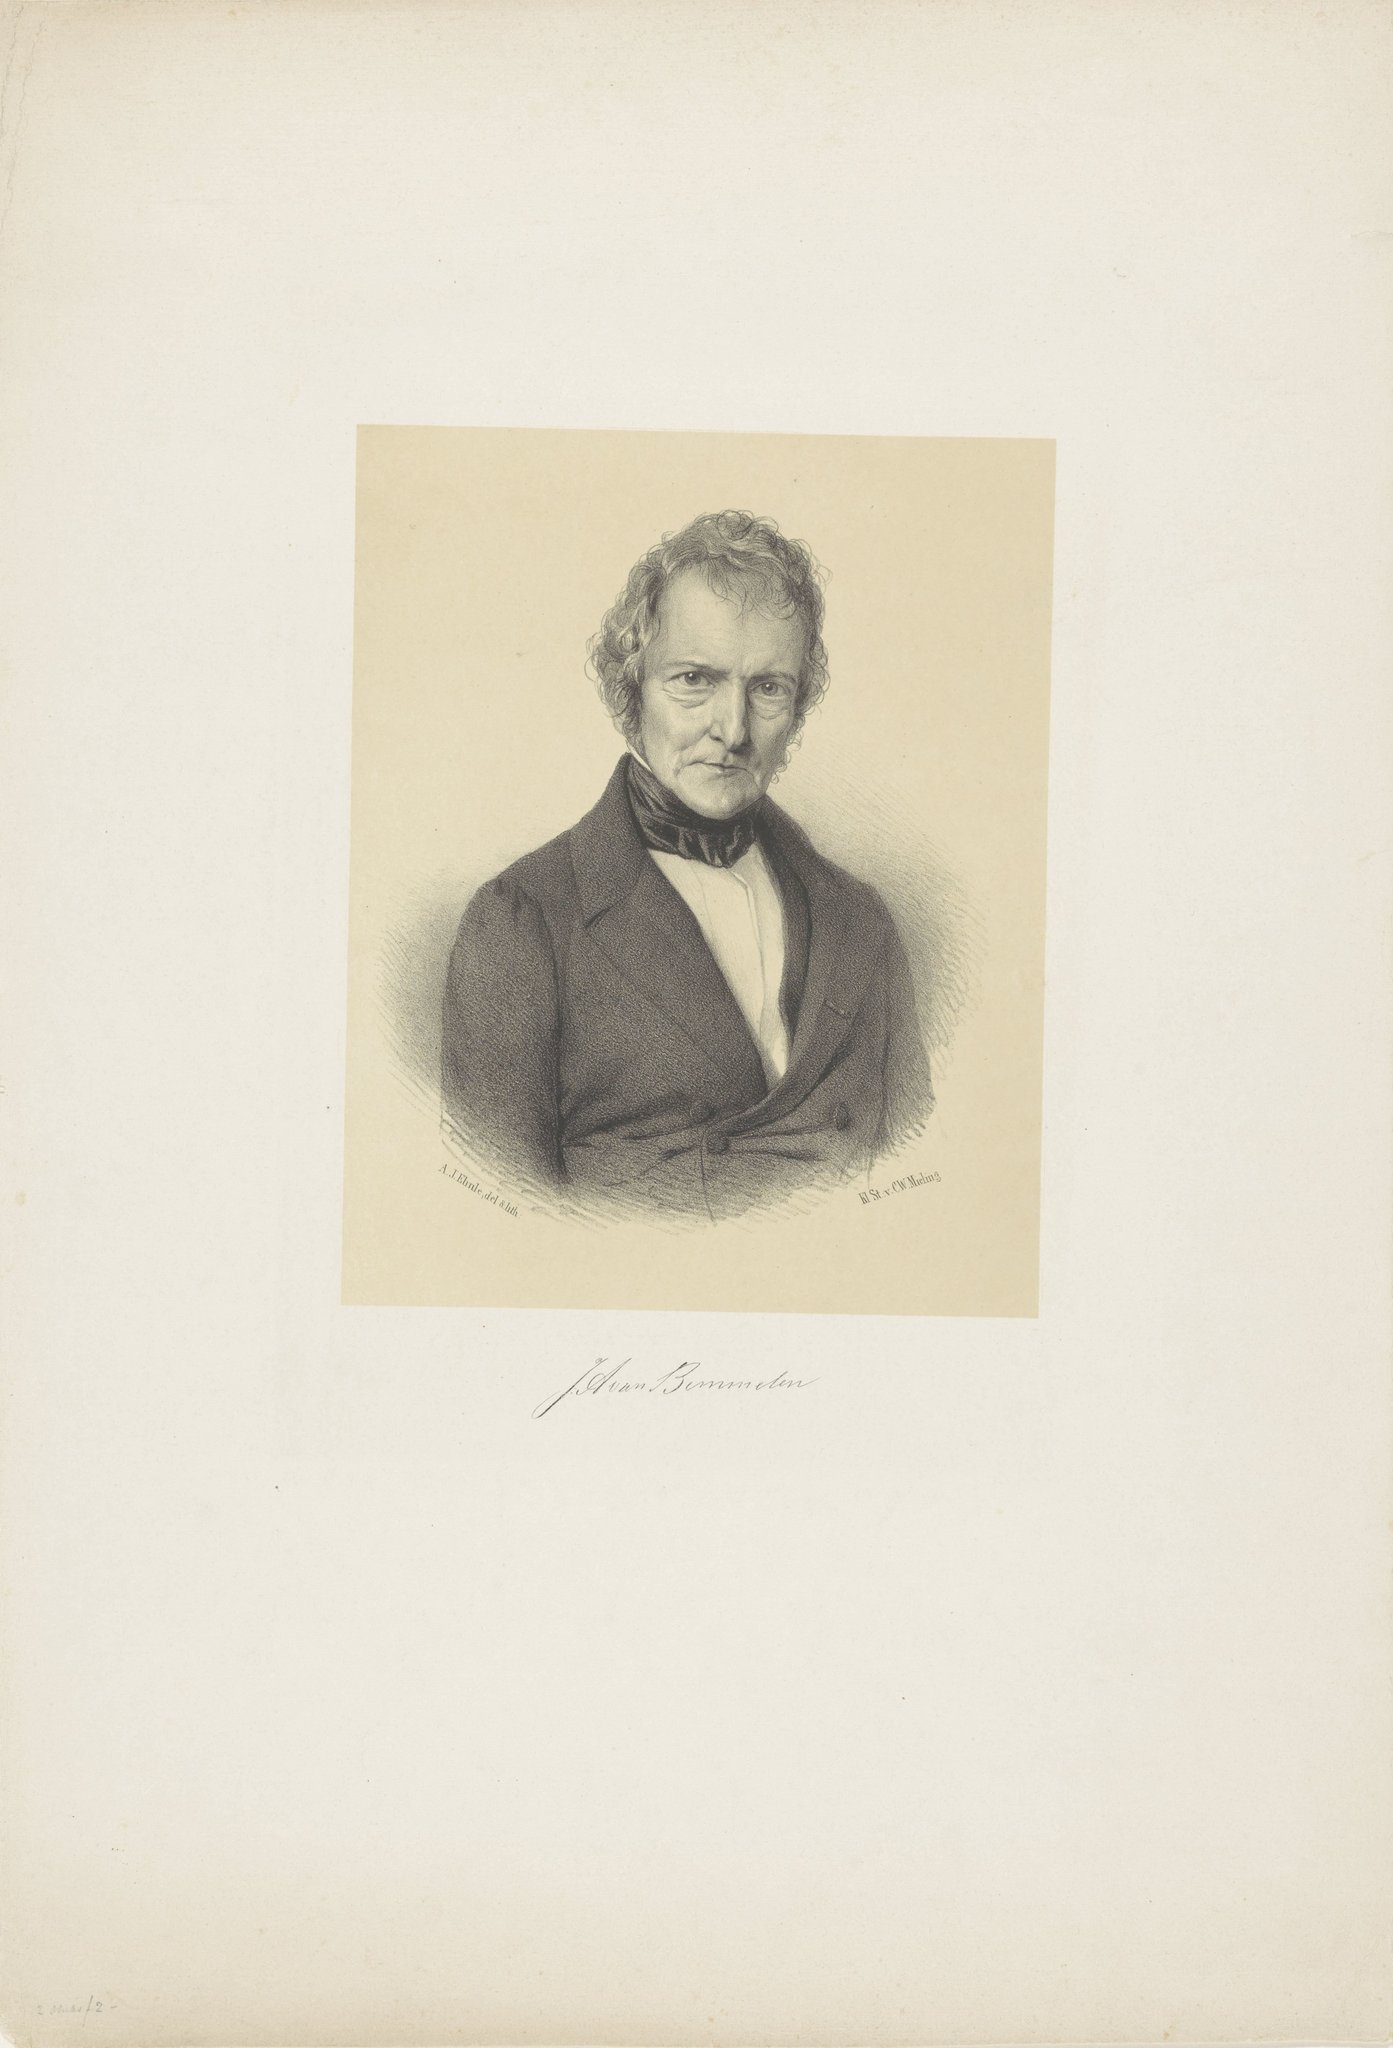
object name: print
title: Portret van J.A. van Bemmelen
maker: adrianus johannes ehnle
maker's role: draughtsman, print maker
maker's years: 1819-1863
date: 1829-1853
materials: paper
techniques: tone lithography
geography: the hague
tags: historical persons (+ (full) bust portrait)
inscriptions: collector's mark: Lugt 2228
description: De geportretteerde heeft het hoofd licht gebogen. Onder het portret zijn signatuur.